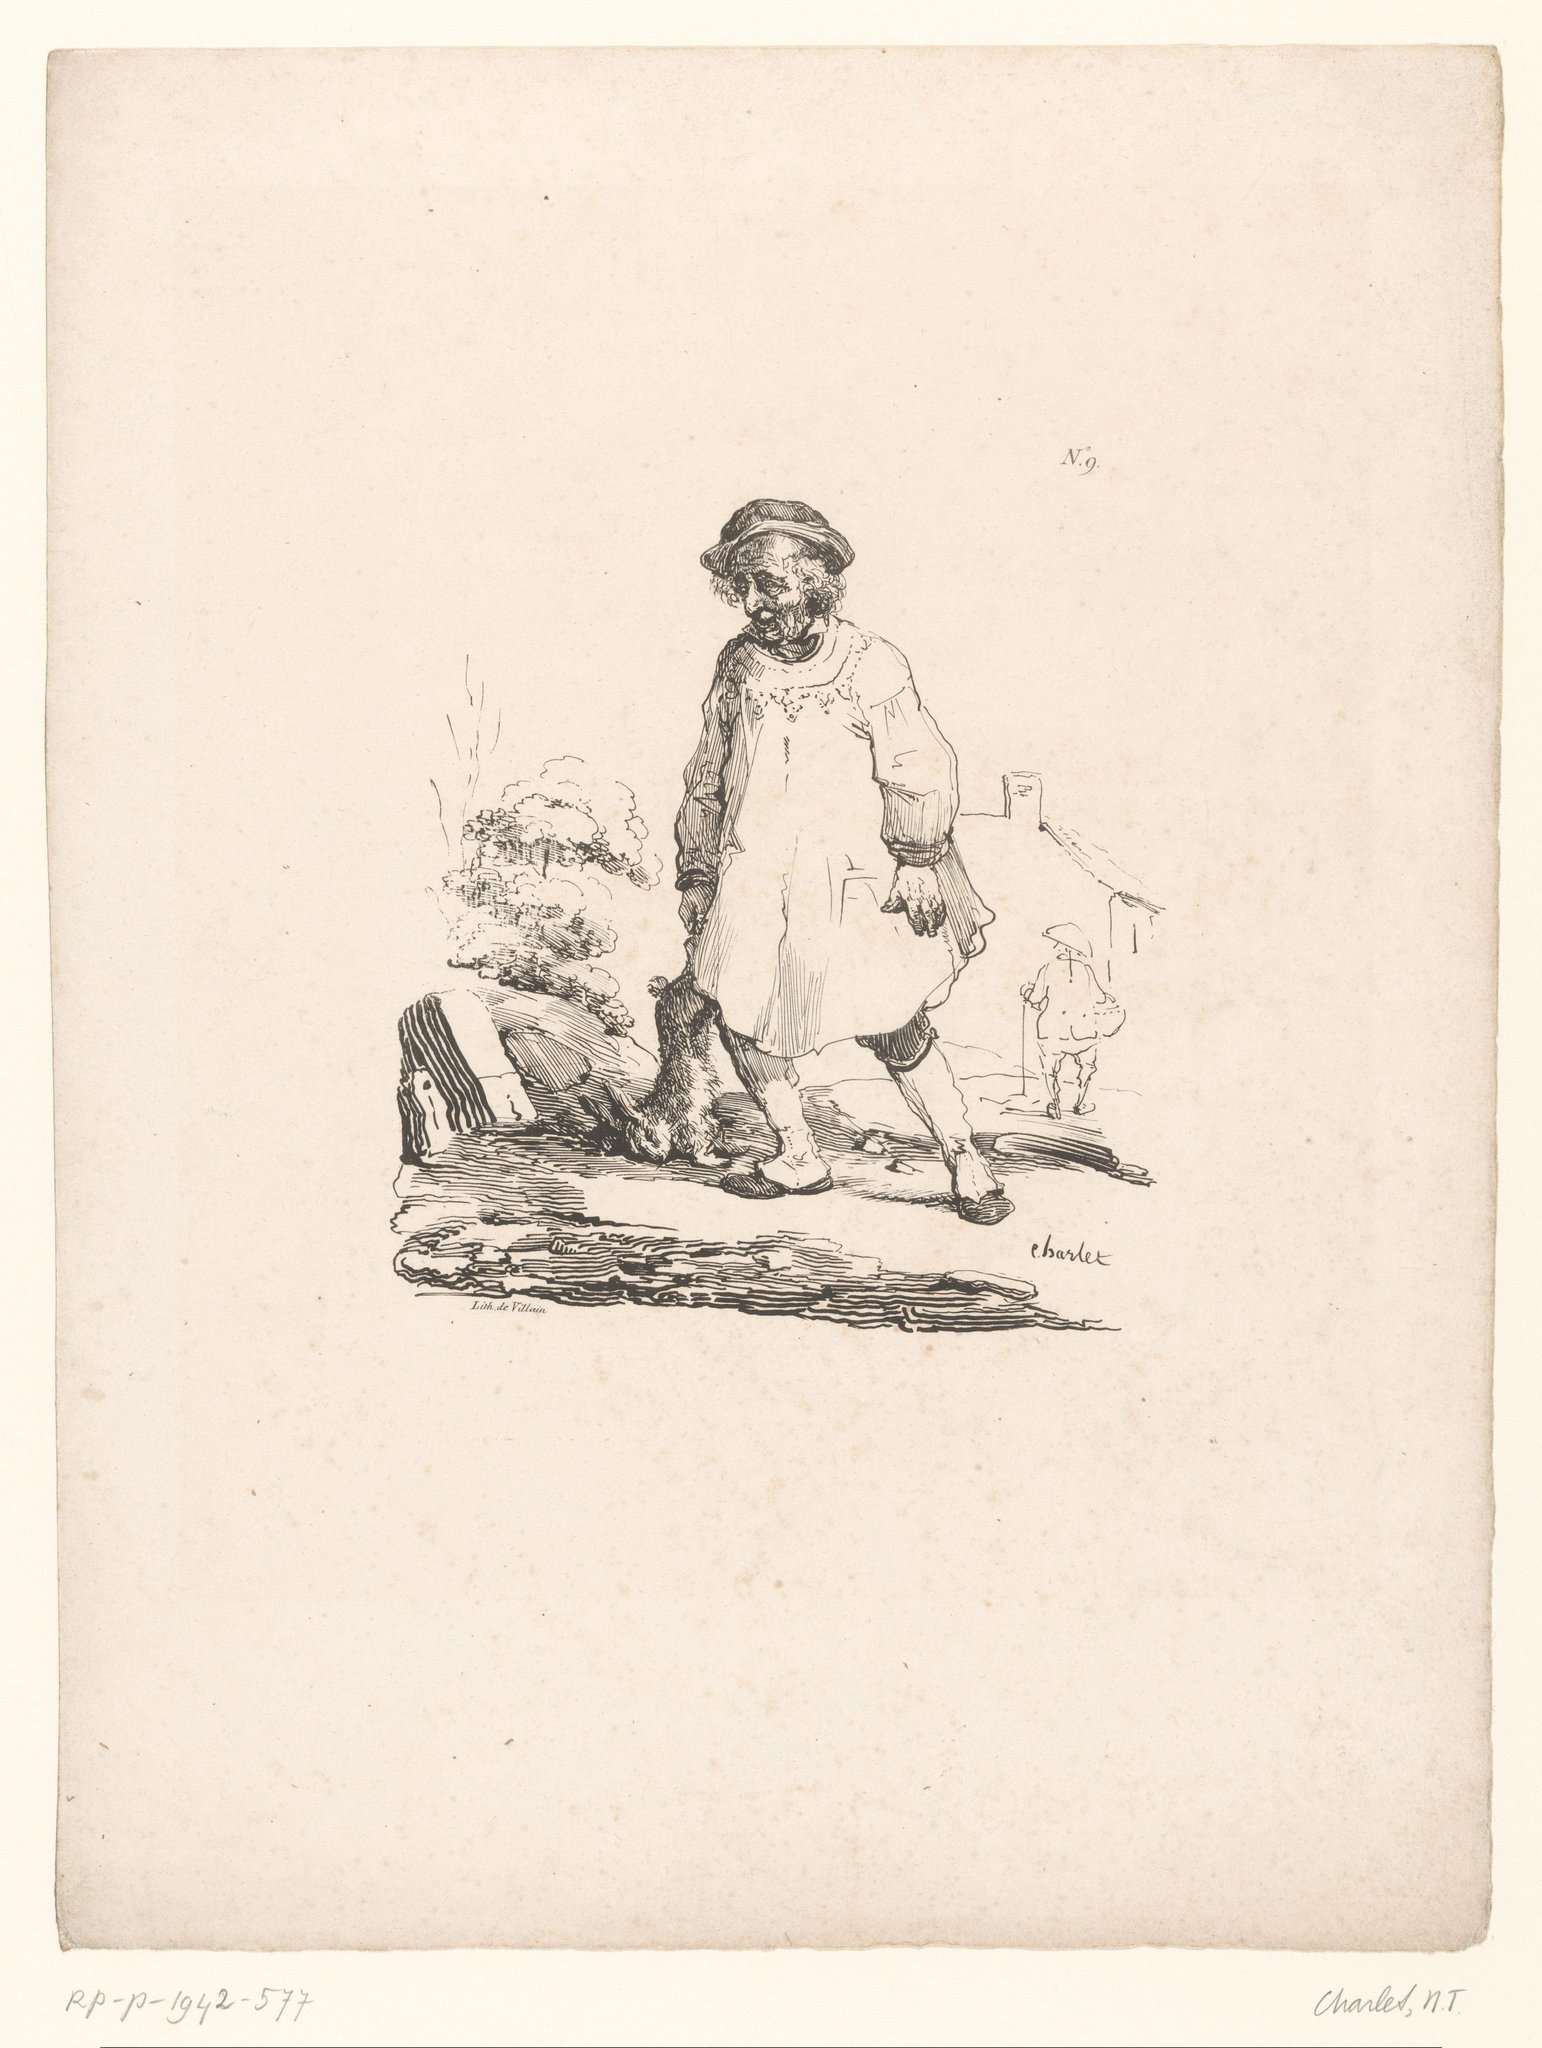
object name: print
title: Lithografische schetsen 1823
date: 1823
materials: paper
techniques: pen lithography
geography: paris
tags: poacher, rodents: hare, hare-hunting, rabbit-hunting